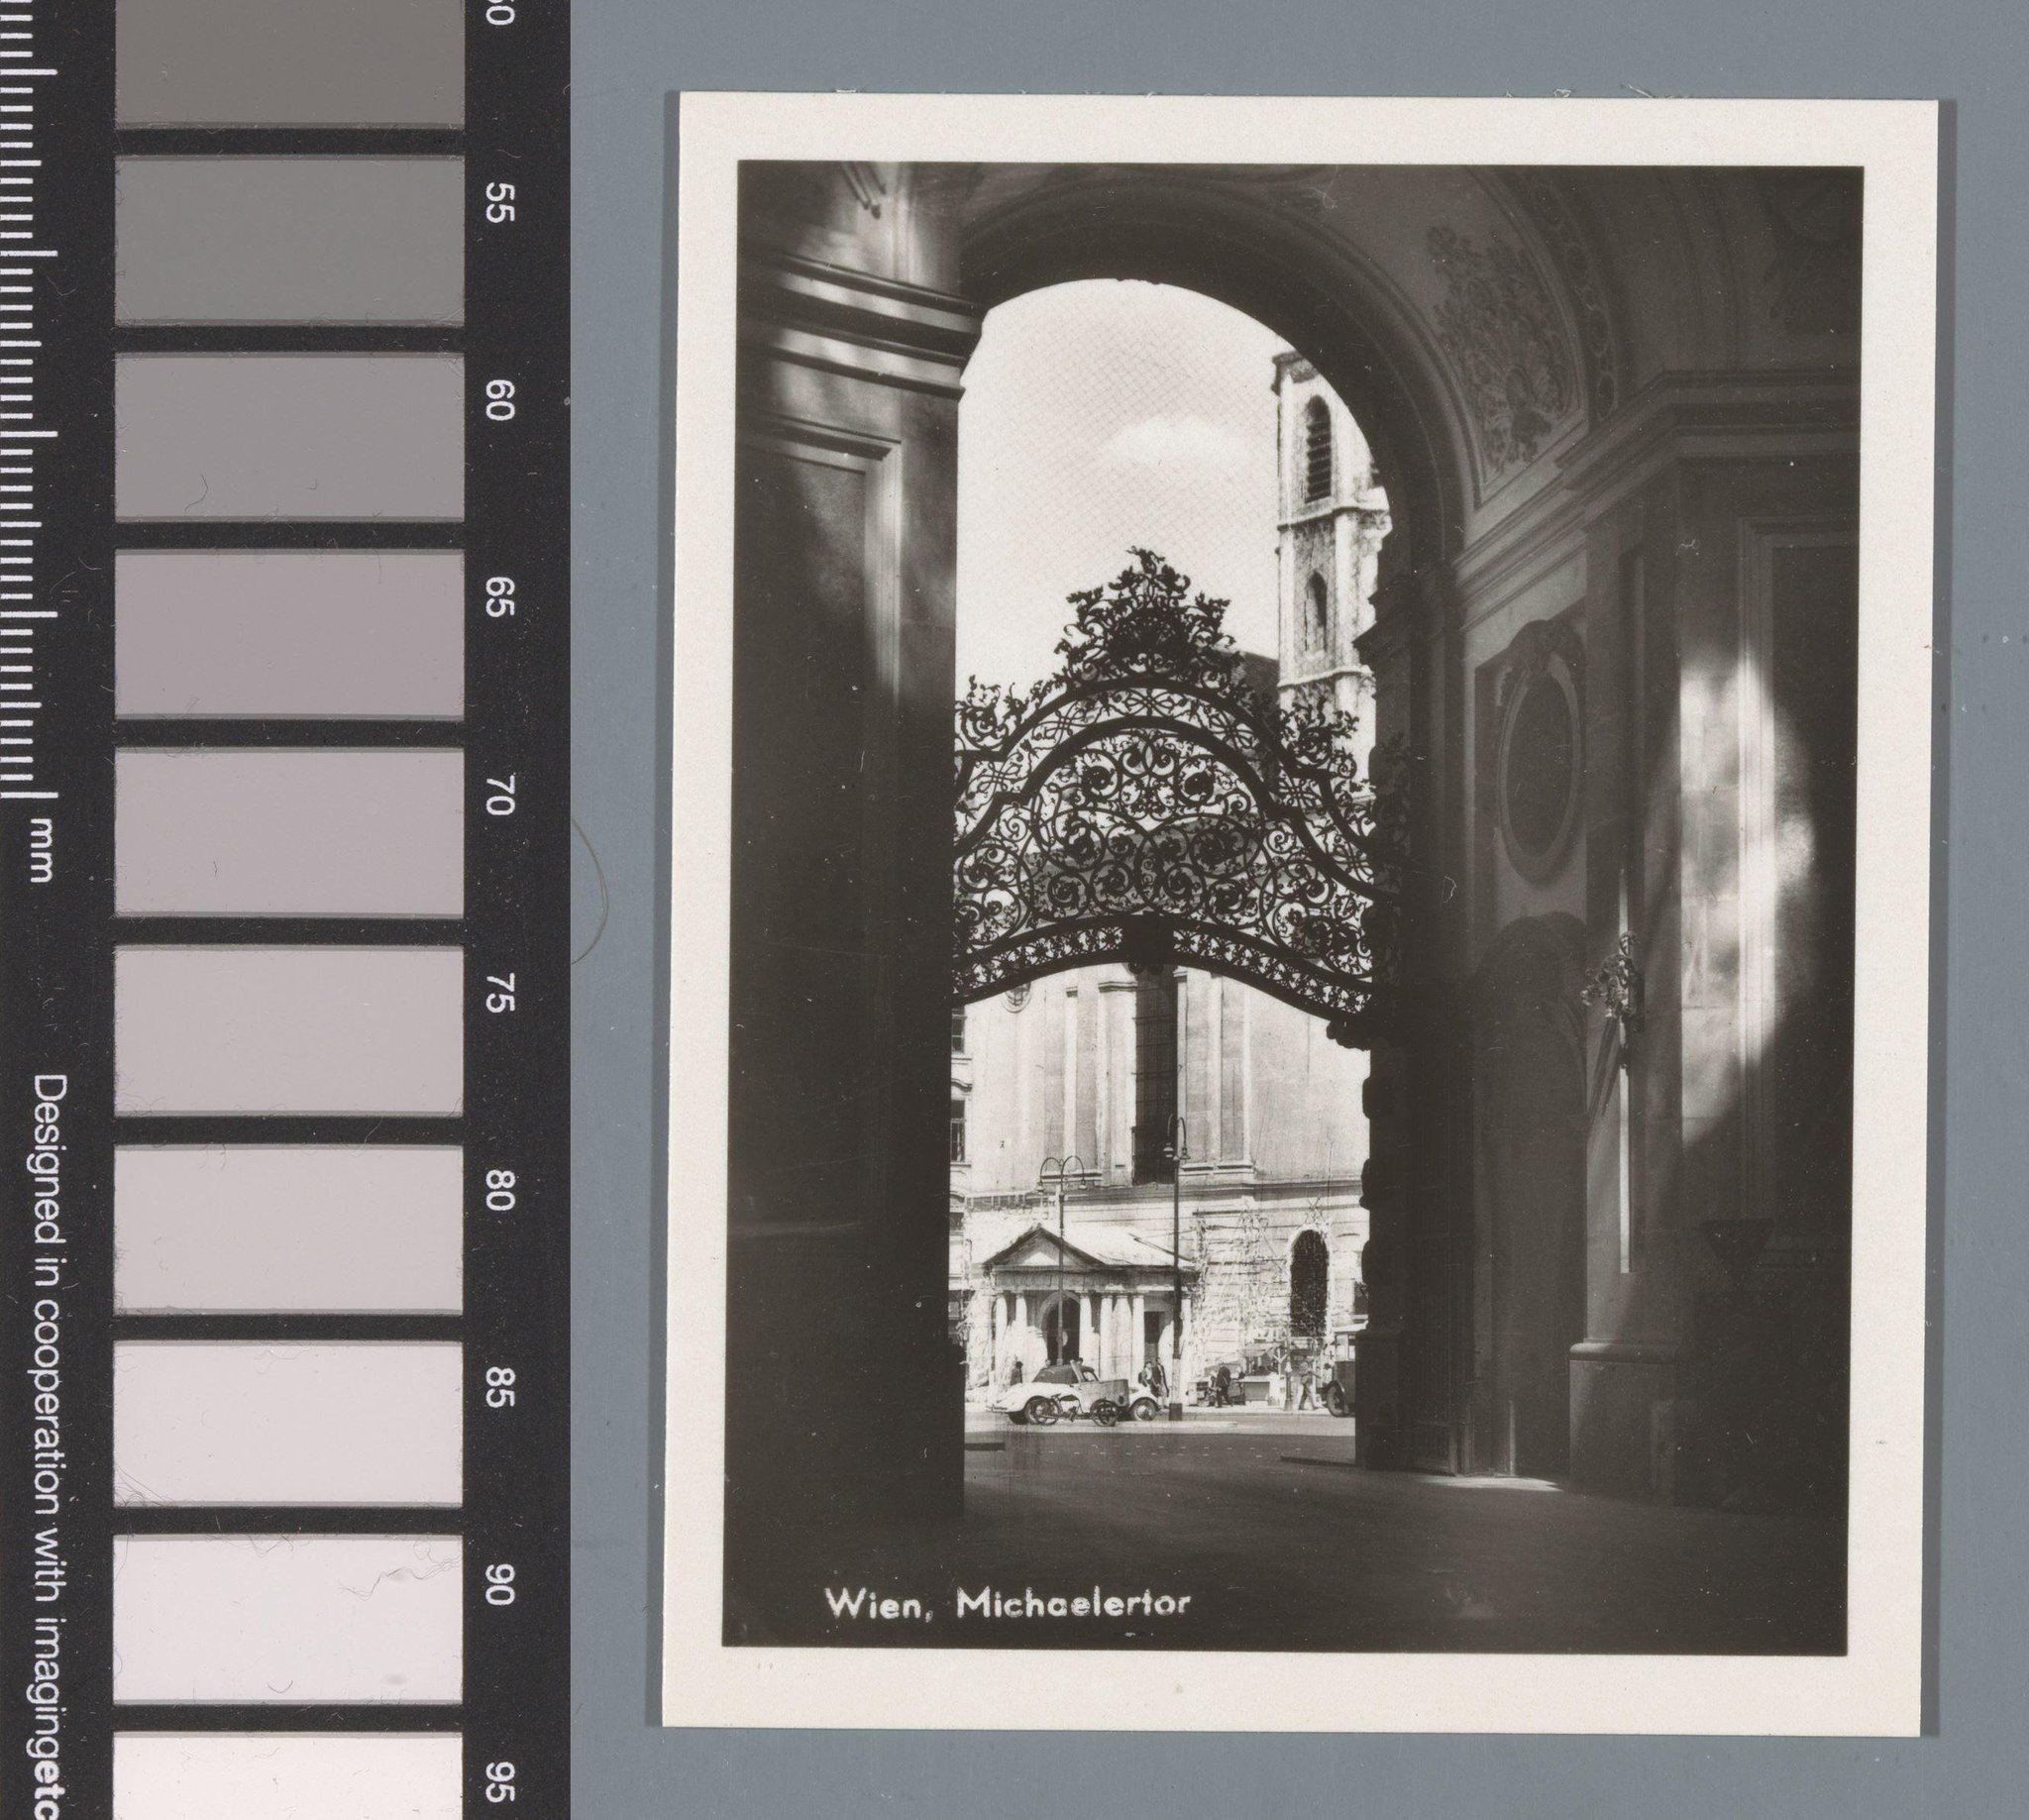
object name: photograph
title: Gezicht door de Michaelertor in Wenen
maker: Anonymous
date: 1950-1960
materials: photographic support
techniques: gelatin silver print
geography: vienna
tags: gate, entrance, vienna